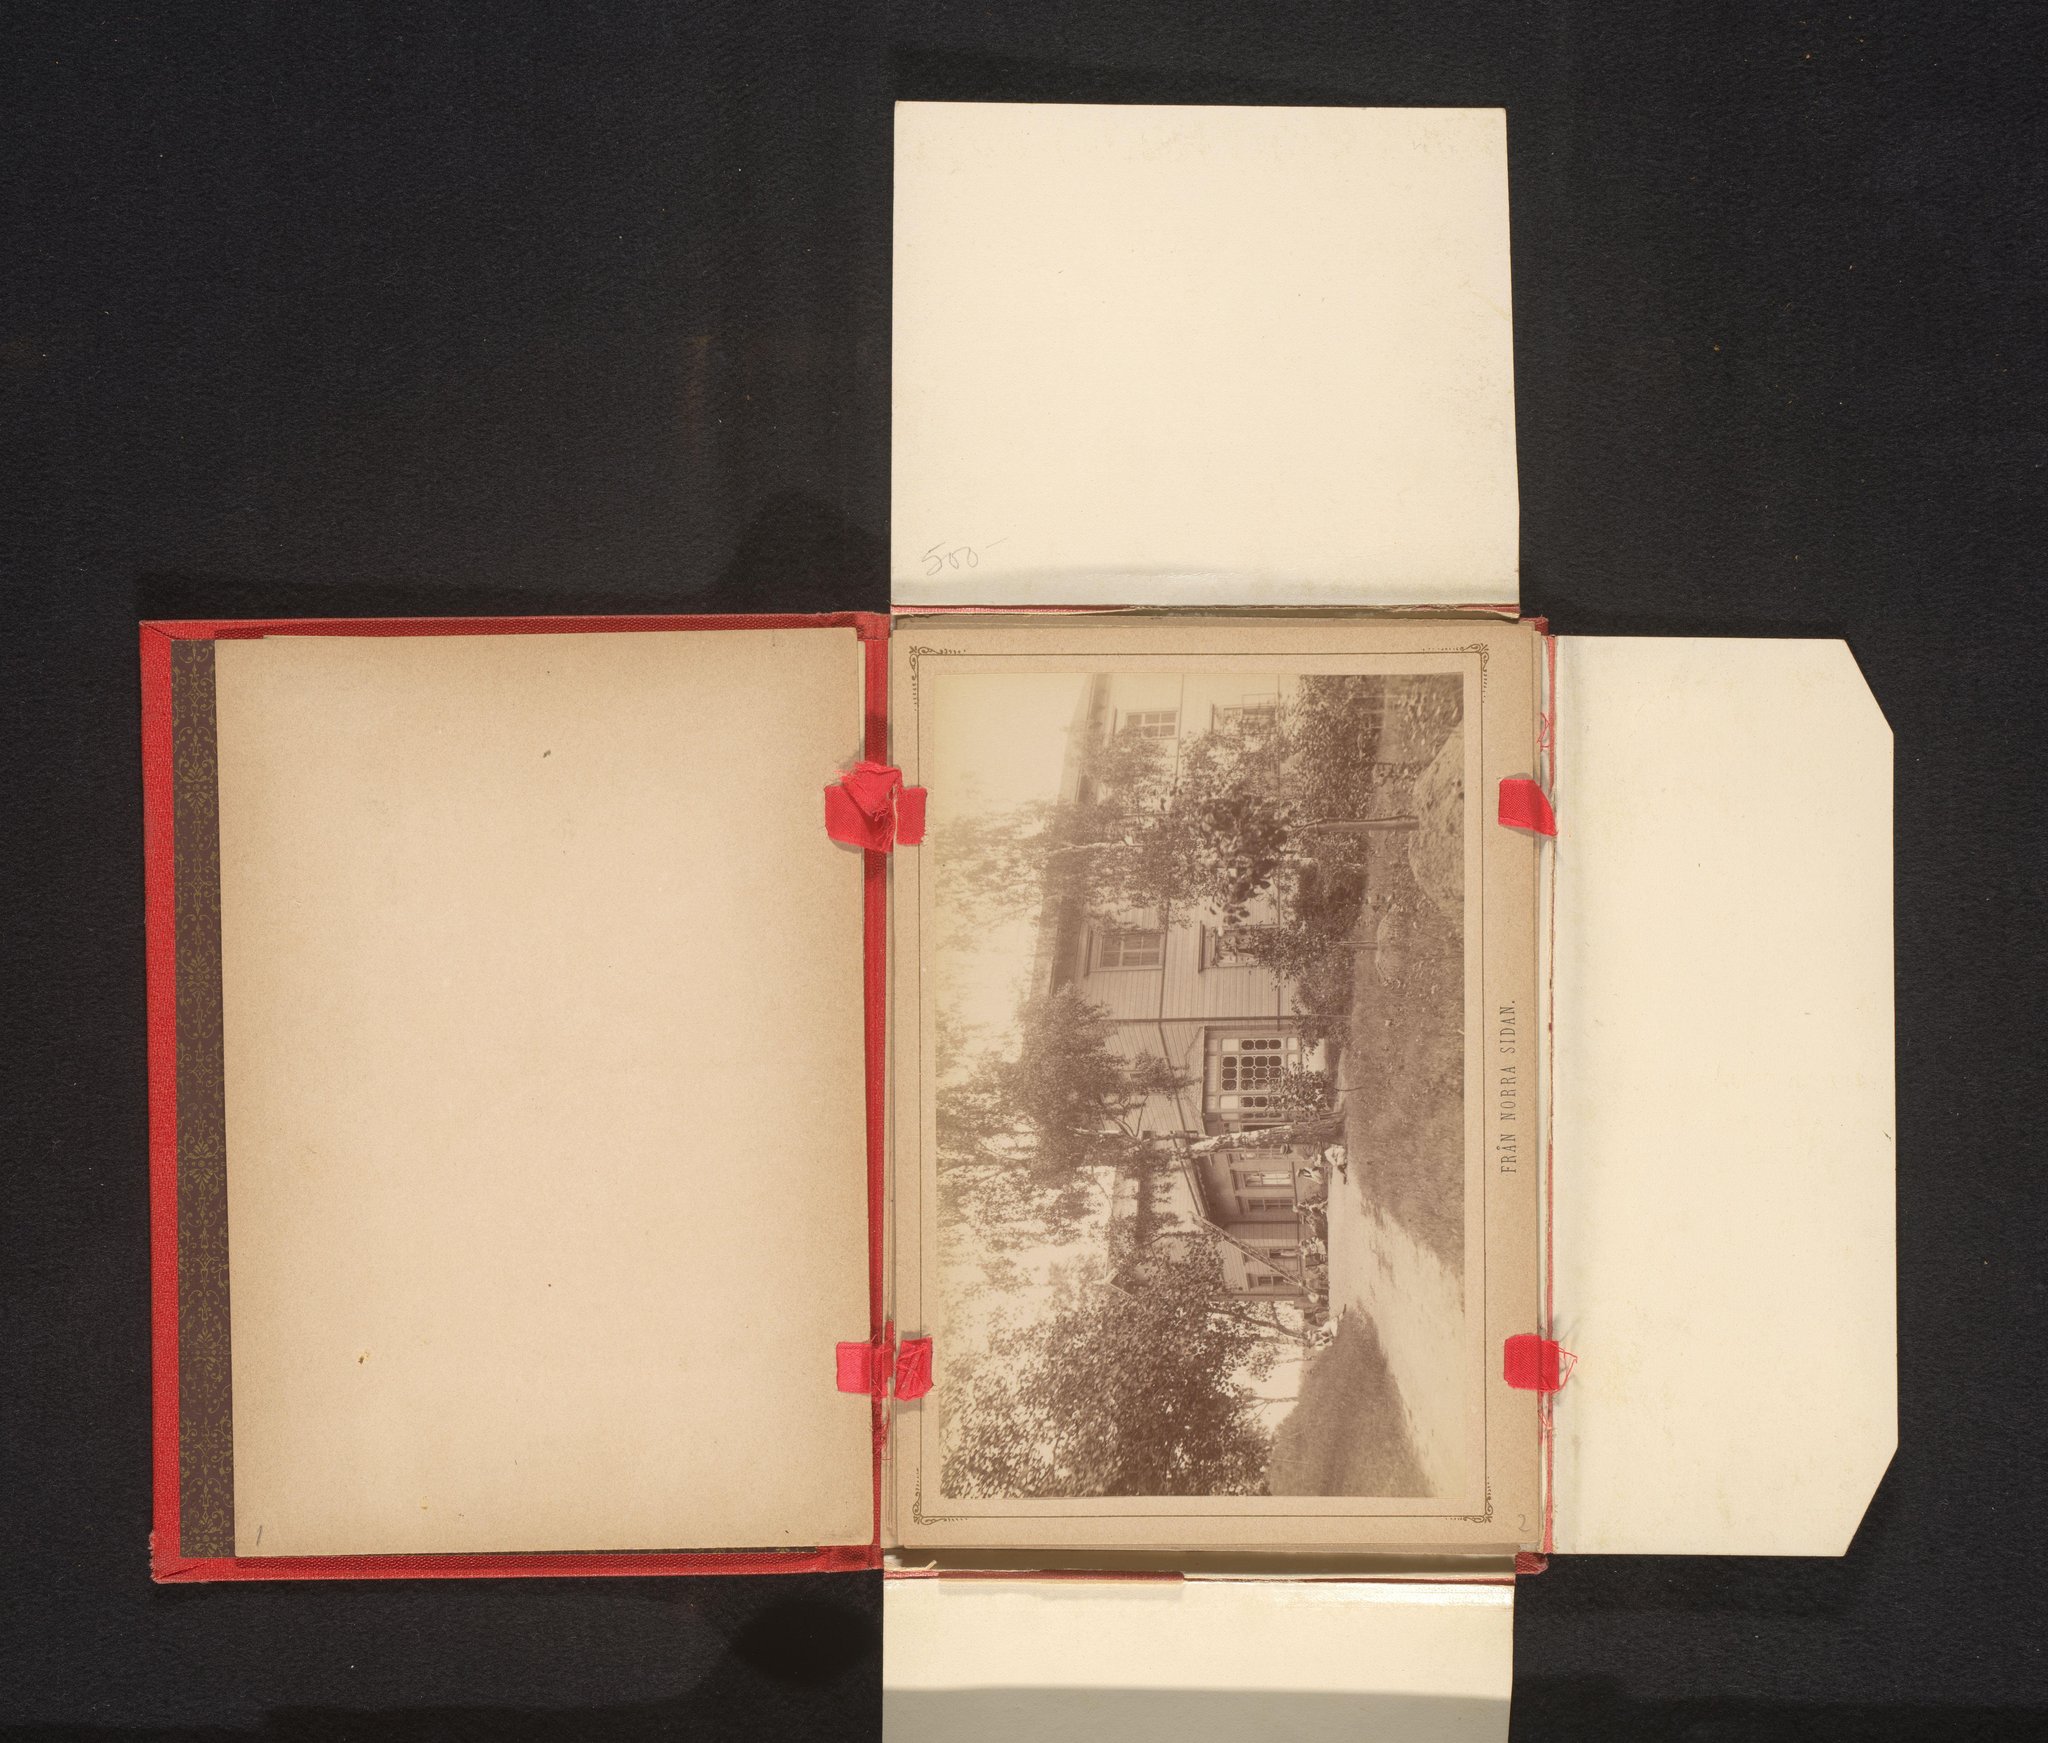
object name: photograph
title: Exterieur van het landhuis Koivuniemi te Helsinki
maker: daniel nyblin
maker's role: fotograaf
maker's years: 1856-1923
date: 1879-1884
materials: photographic support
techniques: albumen print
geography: helsinki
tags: rural housing, e.g. country-house, villa, cottage, façade (of house or building)